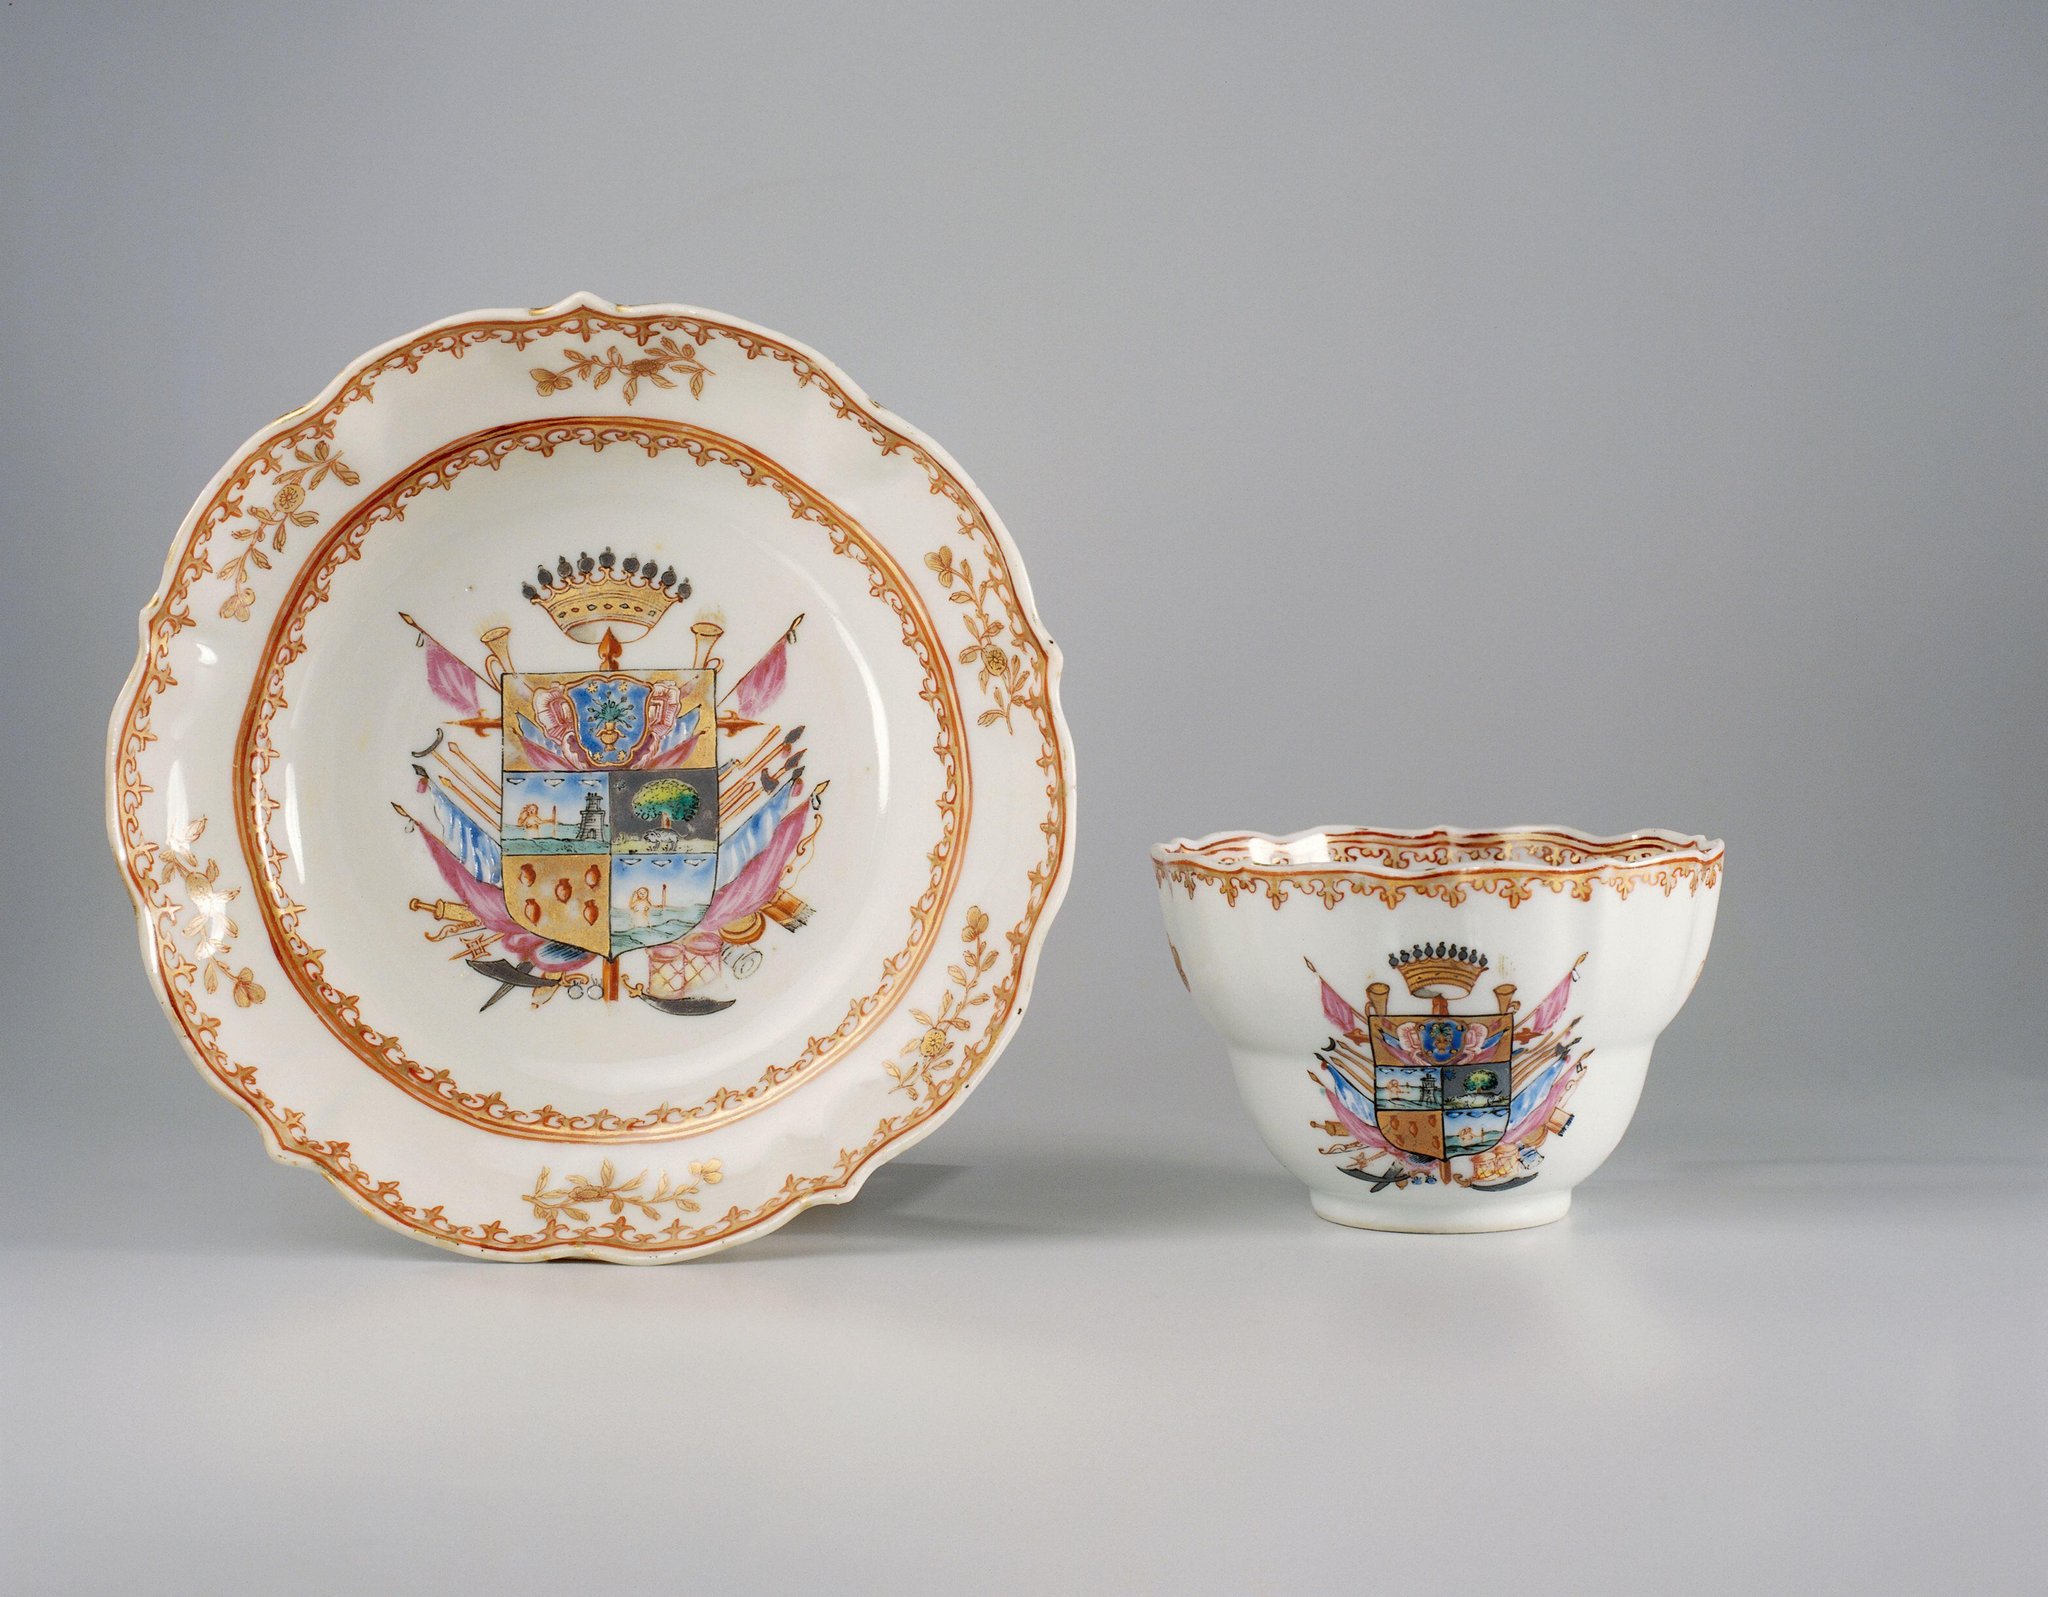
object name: kop en schotel, kop en schotel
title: Saucer with a coat of arms, flower sprays and spearhead-borders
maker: Anonymous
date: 1750-1774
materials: glaze, gold, paint, porcelain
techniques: firing, gilding, turning, vitrification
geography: china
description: Kop met een getrapte wand en schotel, beschilderd in emails en goud met bloemen en een familiewapen.